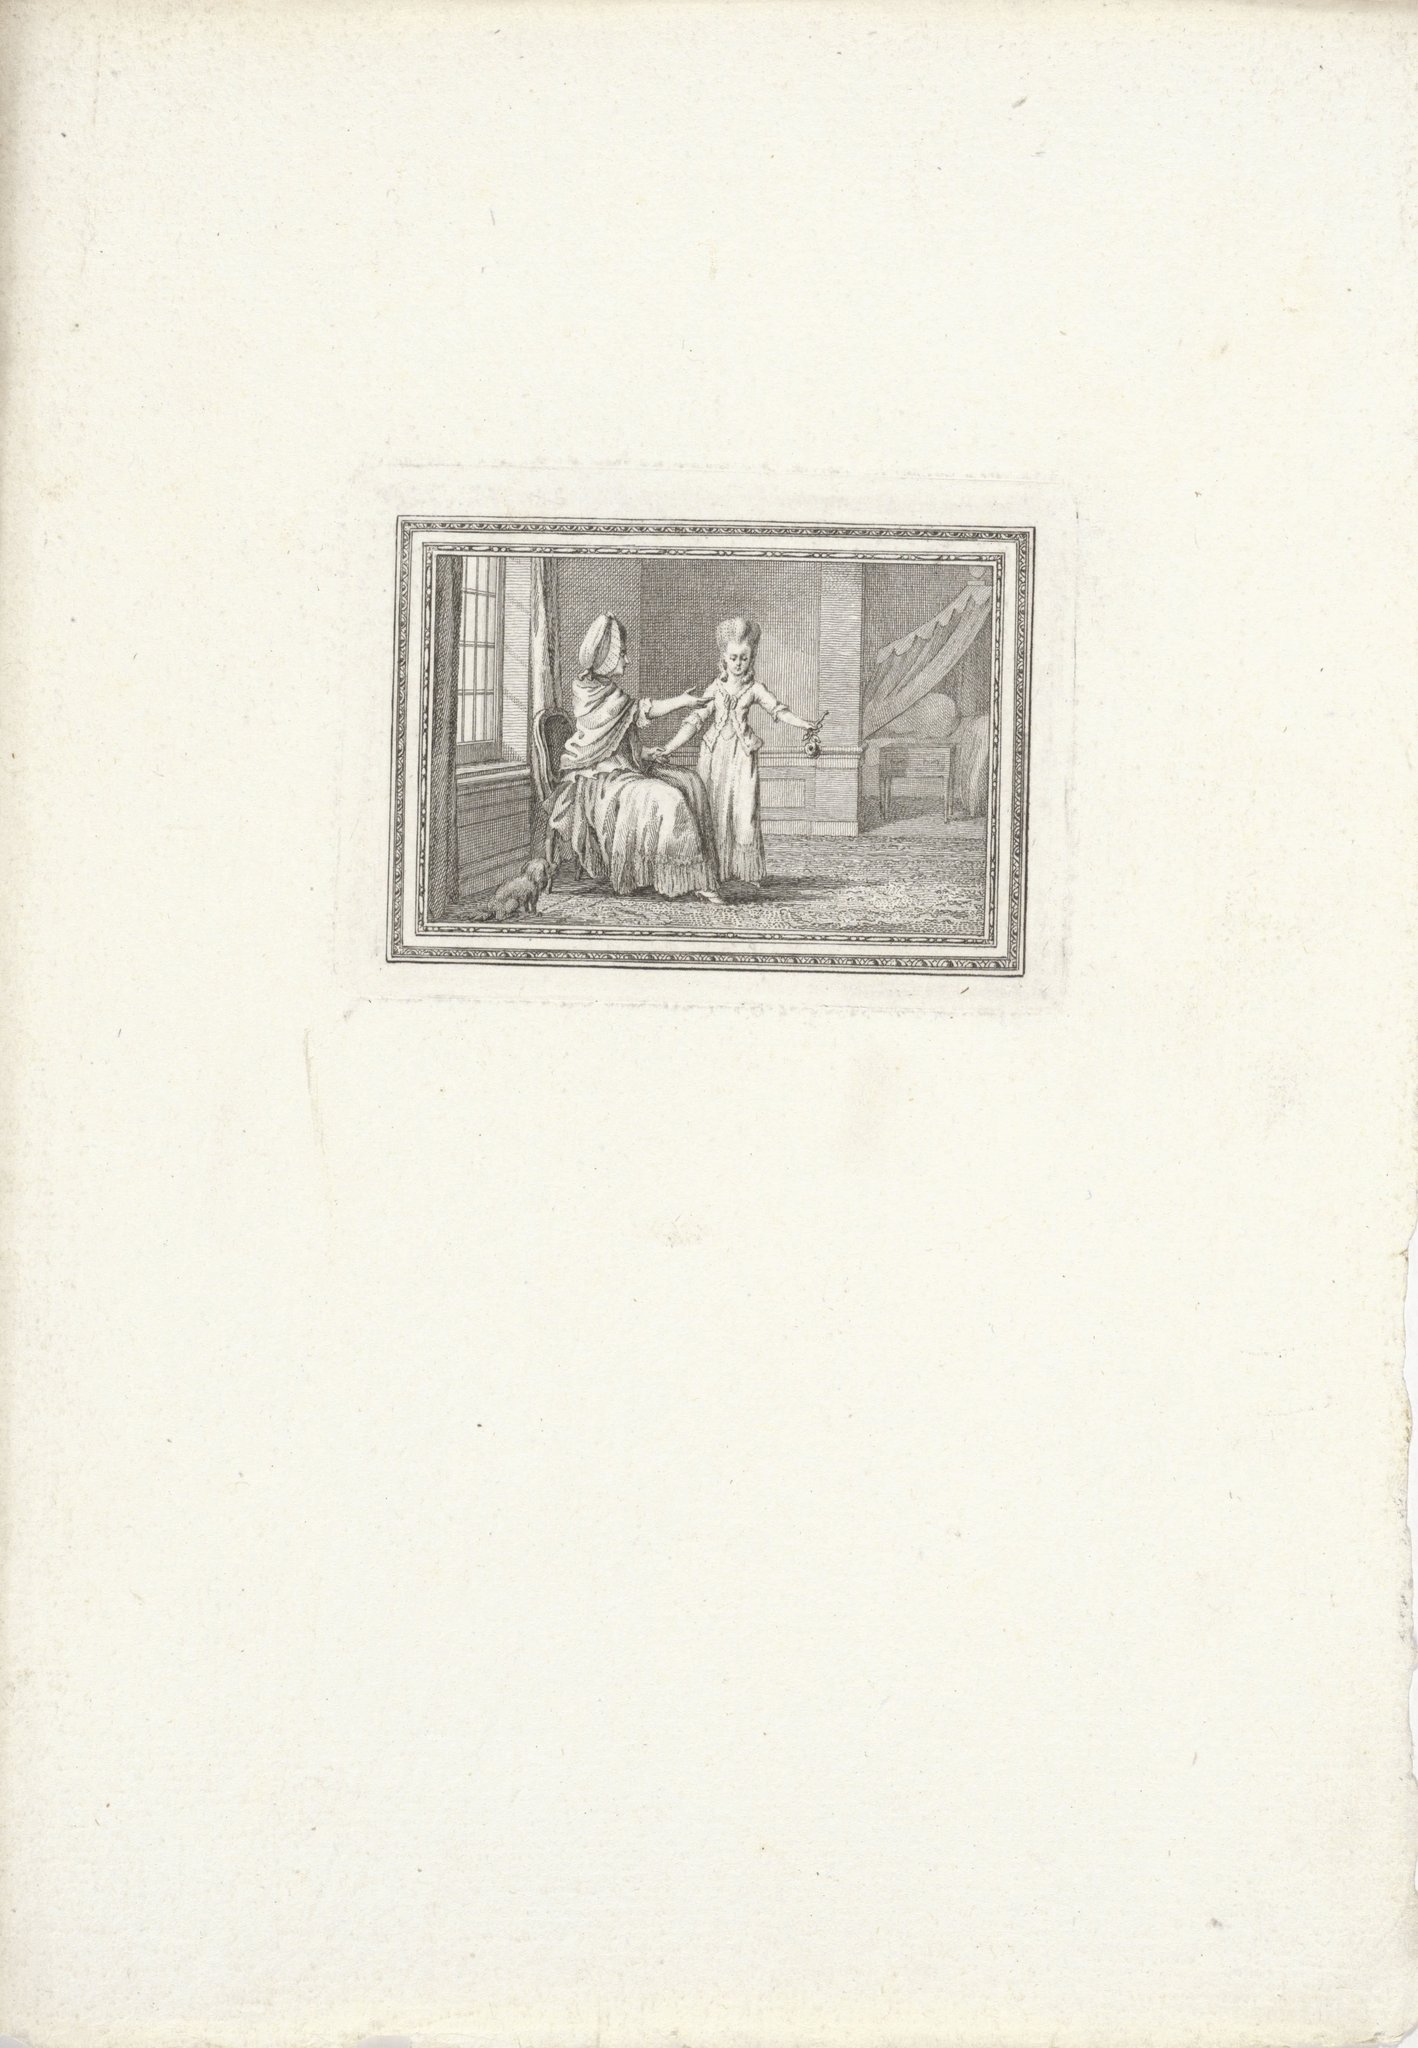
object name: book illustration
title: Coosje en haar moeder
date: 1792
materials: paper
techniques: etching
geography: amsterdam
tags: mother and daughter(s) (family group), flowers: rose, dog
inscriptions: collector's mark: Lugt 2228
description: Coosje toont haar moeder verdrietig een verdorde roos. Illustratie bij het verhaal 'Coosje en hare moeder' uit 'Fabelen voor de Nederlandsche jeugd'.